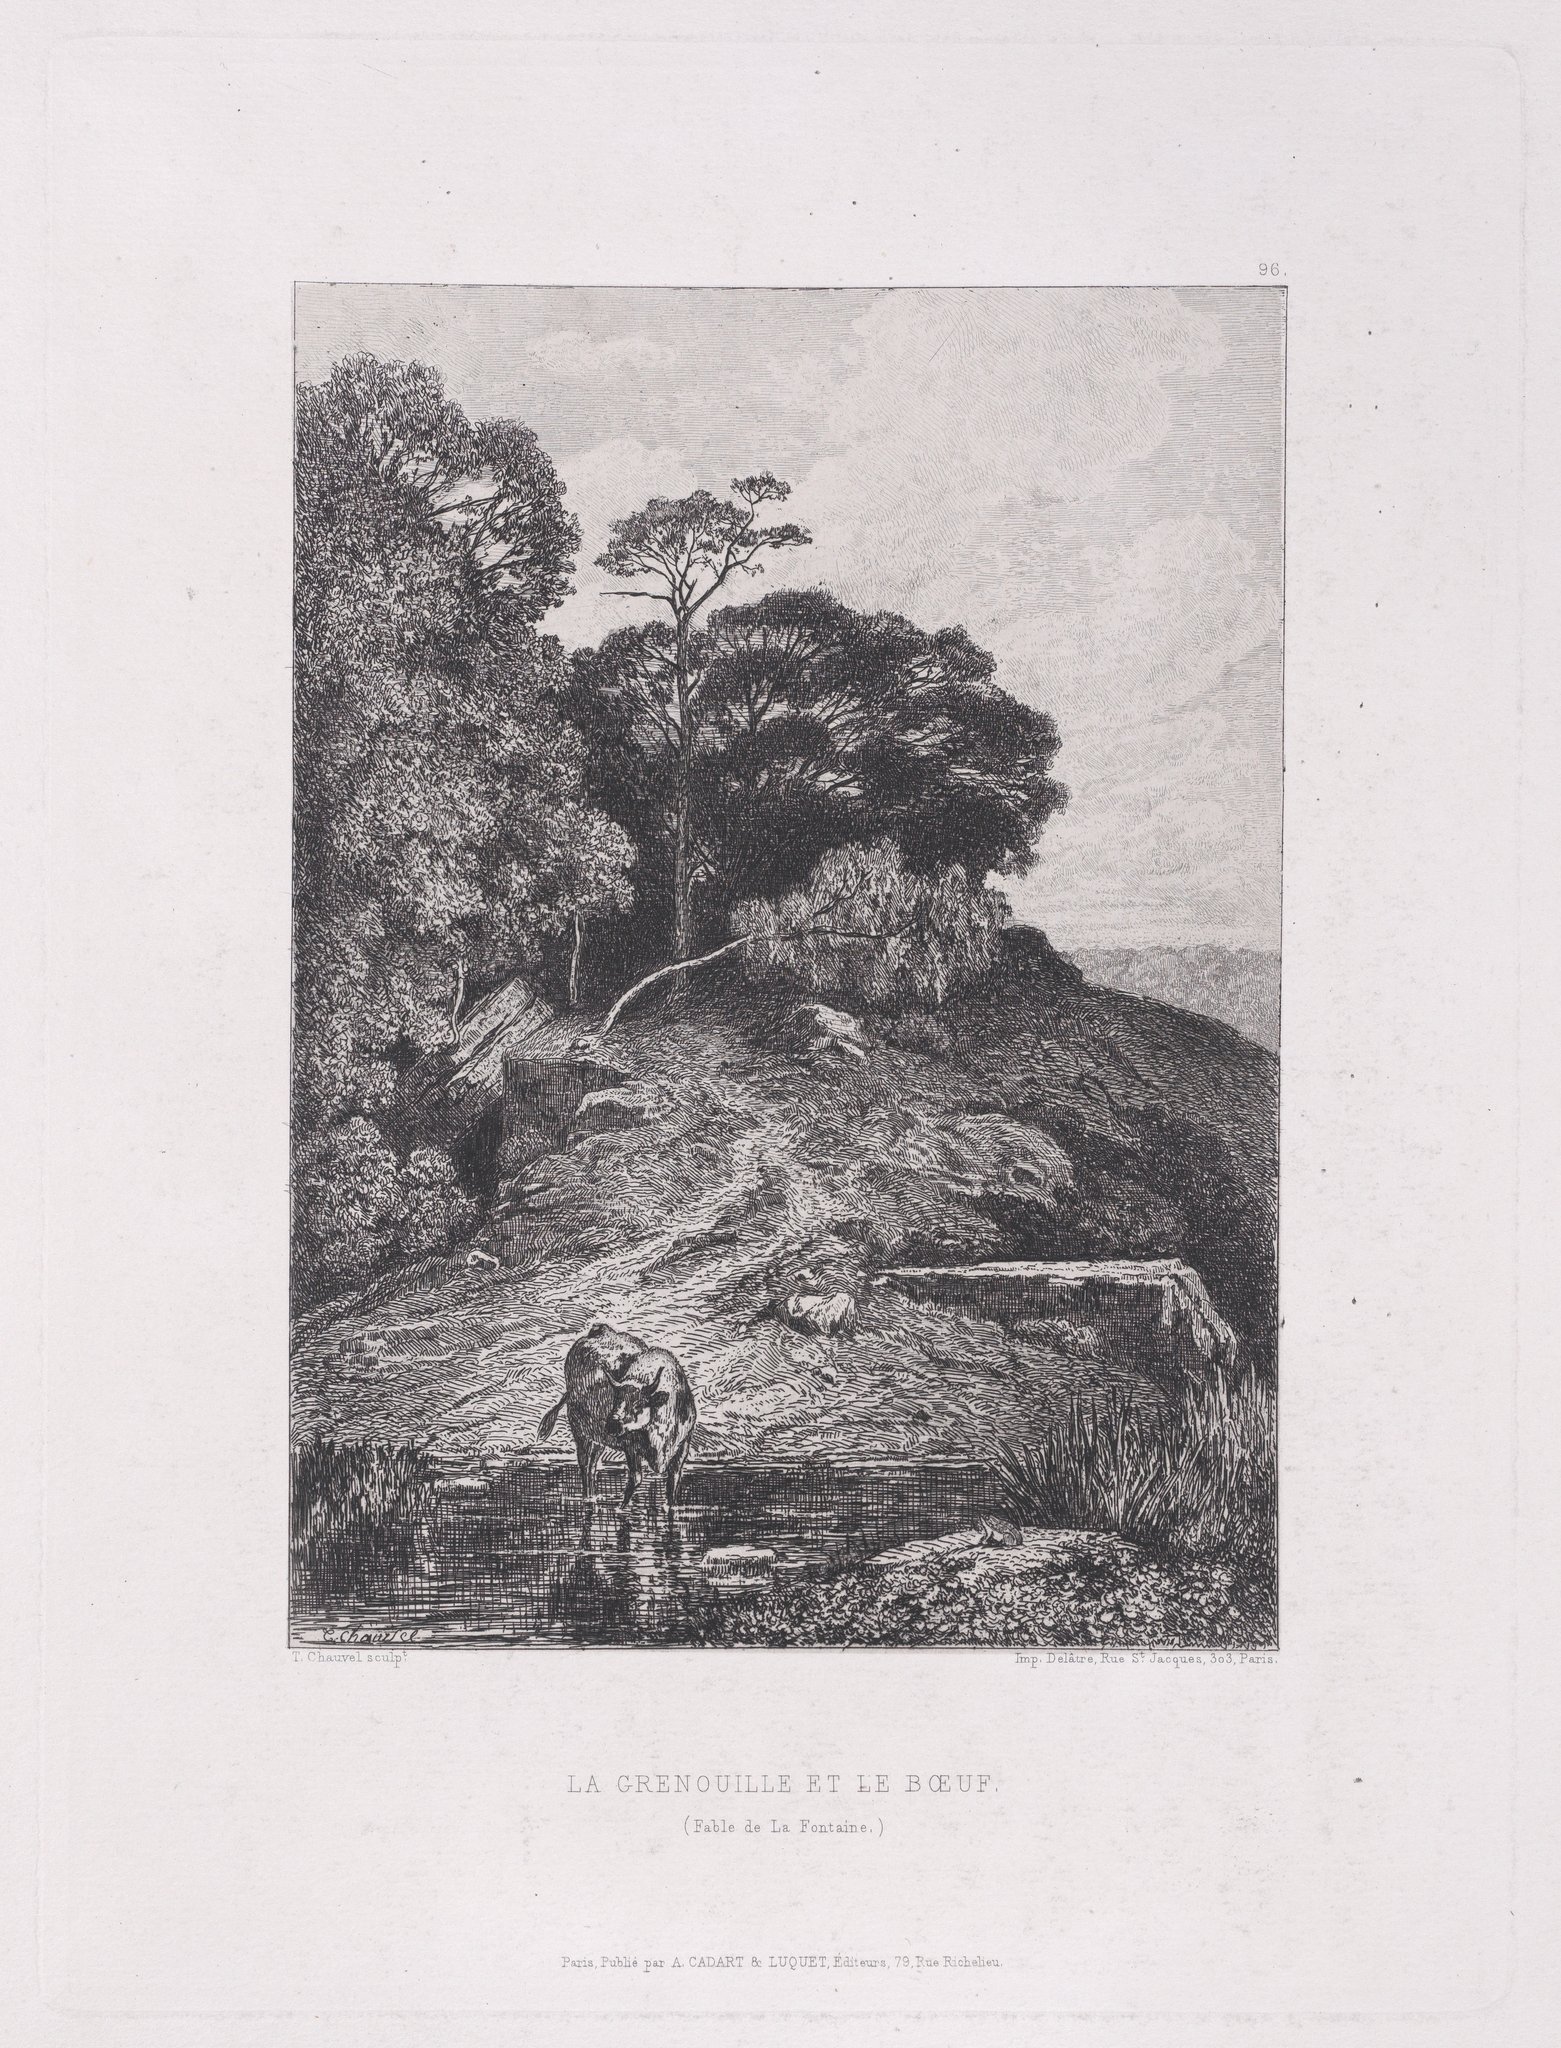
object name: print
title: La Grenouille et la Boeuf, plate 96 from "Fable de la Fontaine"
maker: théophile chauvel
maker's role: artist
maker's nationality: french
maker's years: 1831-1909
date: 1864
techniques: etching